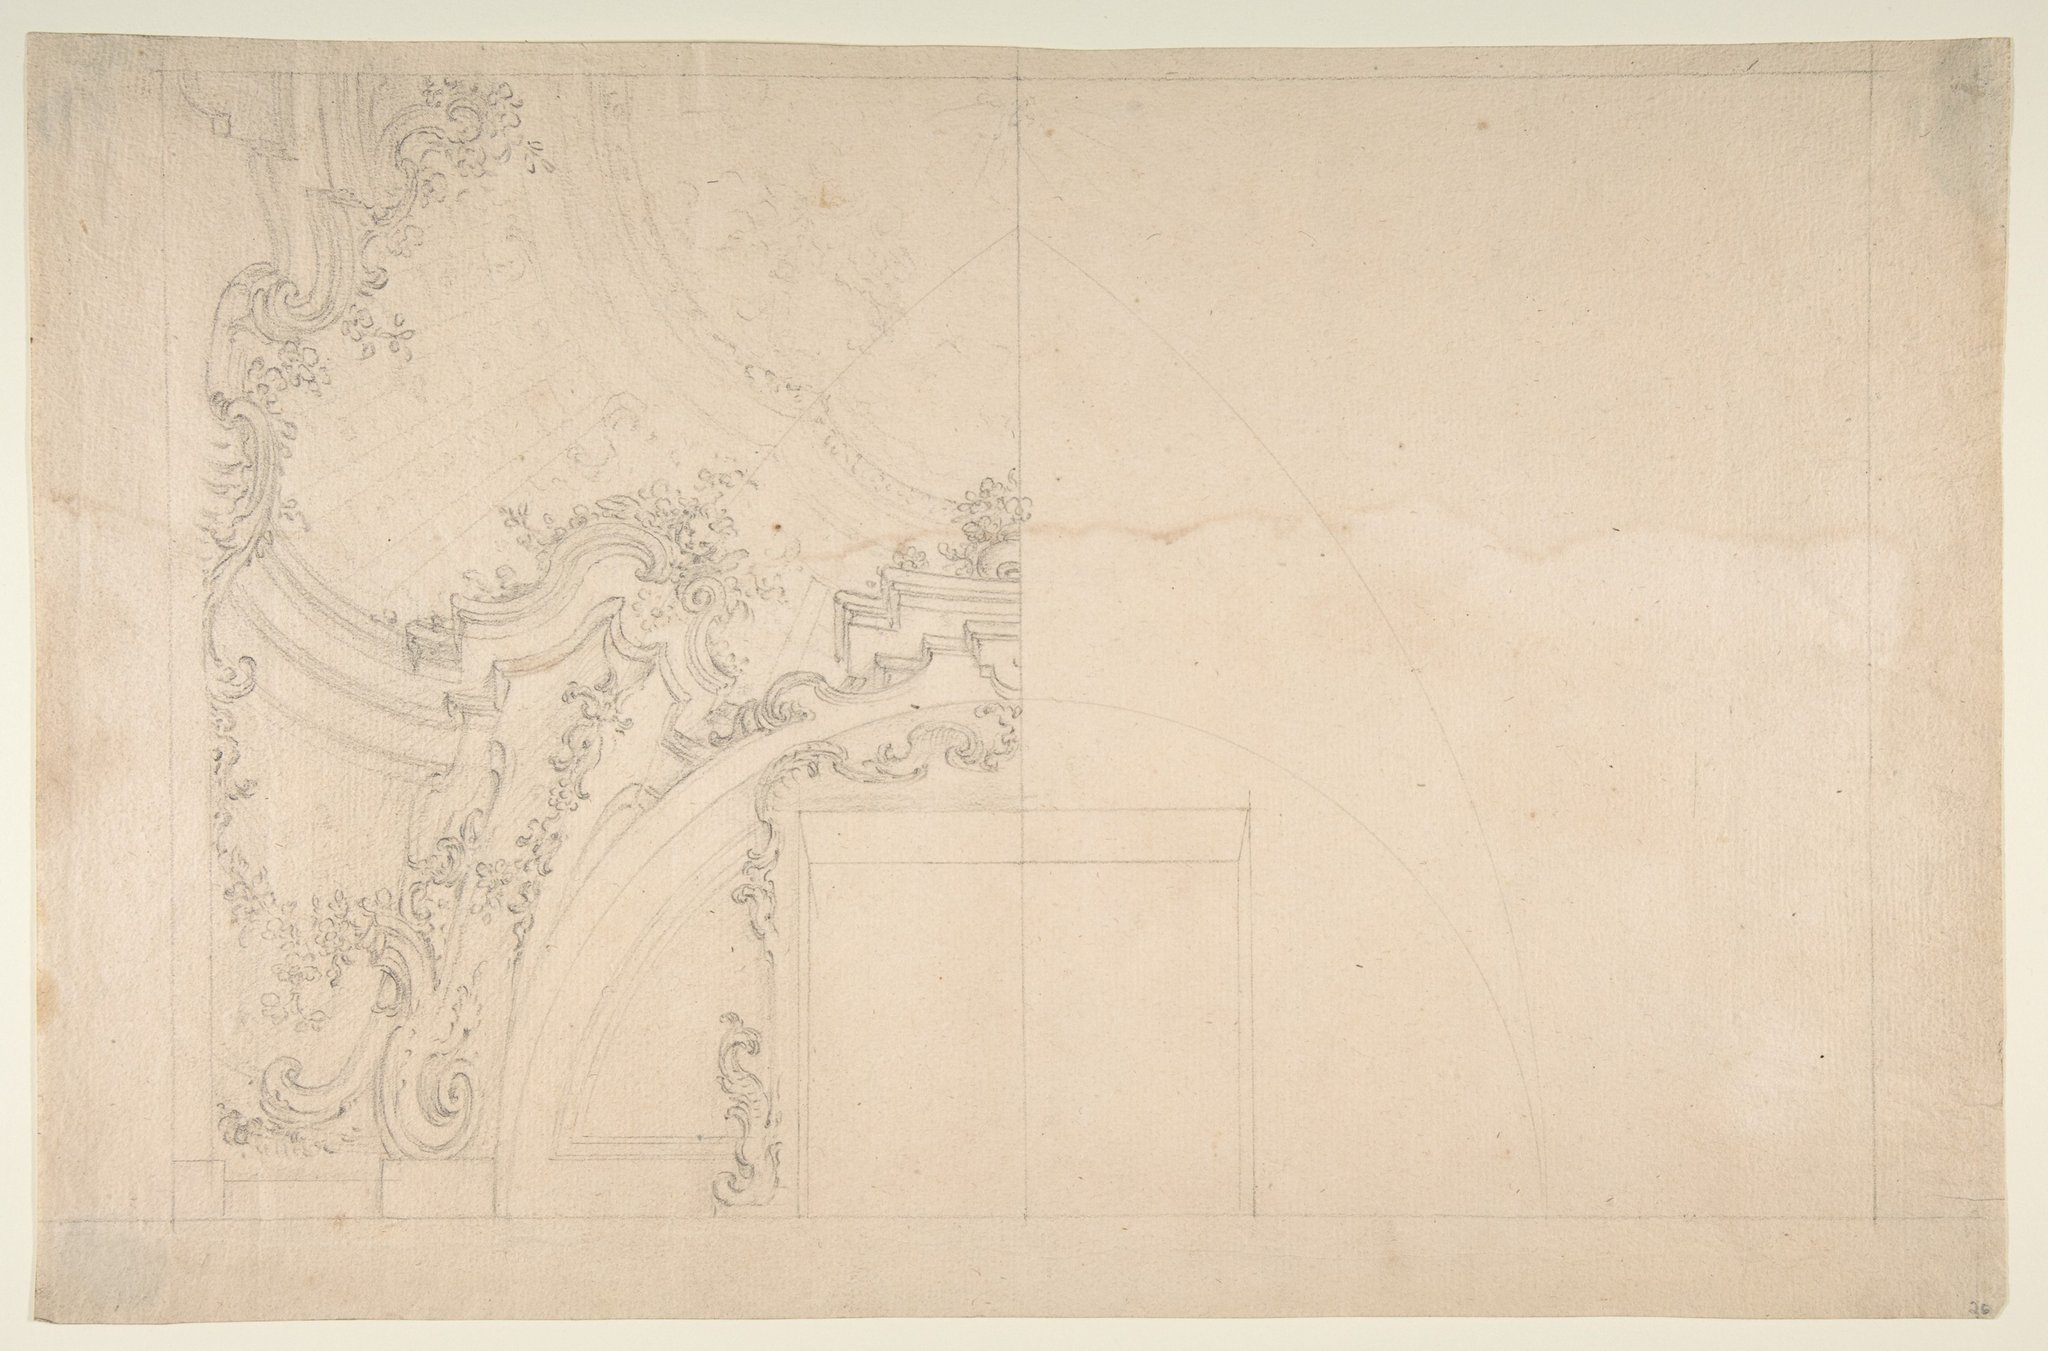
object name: drawing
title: Design for Ceiling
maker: leonardo marini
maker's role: artist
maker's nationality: italian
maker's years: 1730-1797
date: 1701-1800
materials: graphite, drawing material